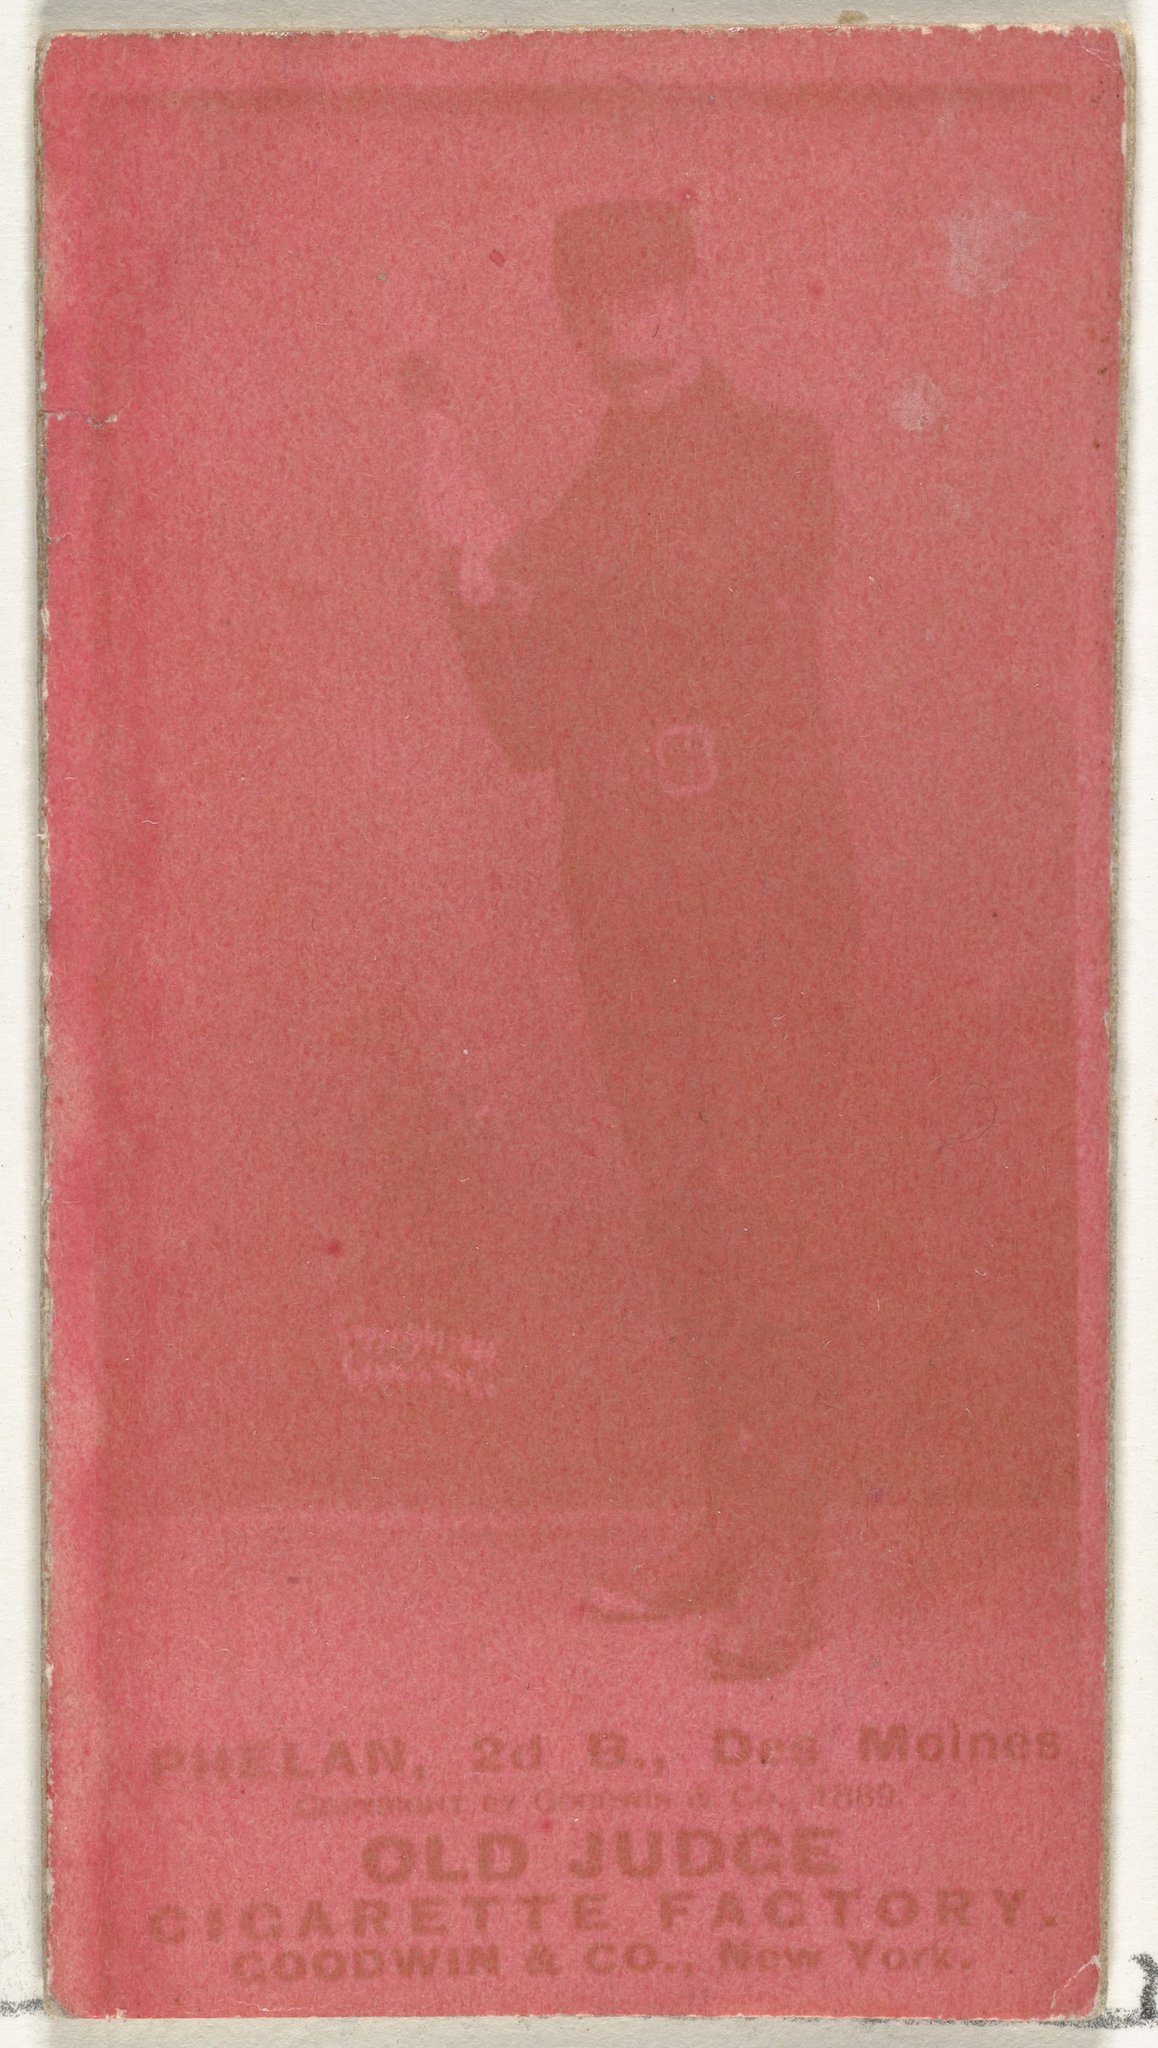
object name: baseball card, photograph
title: James Dickson "Dick" Phelan, 2nd Base, Des Moines Prohibitionists, from the Old Judge series (N172) for Old Judge Cigarettes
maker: goodwin & company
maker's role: publisher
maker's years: 1850-1950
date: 1889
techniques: albumen silver print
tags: men,portraits,baseball,athletes